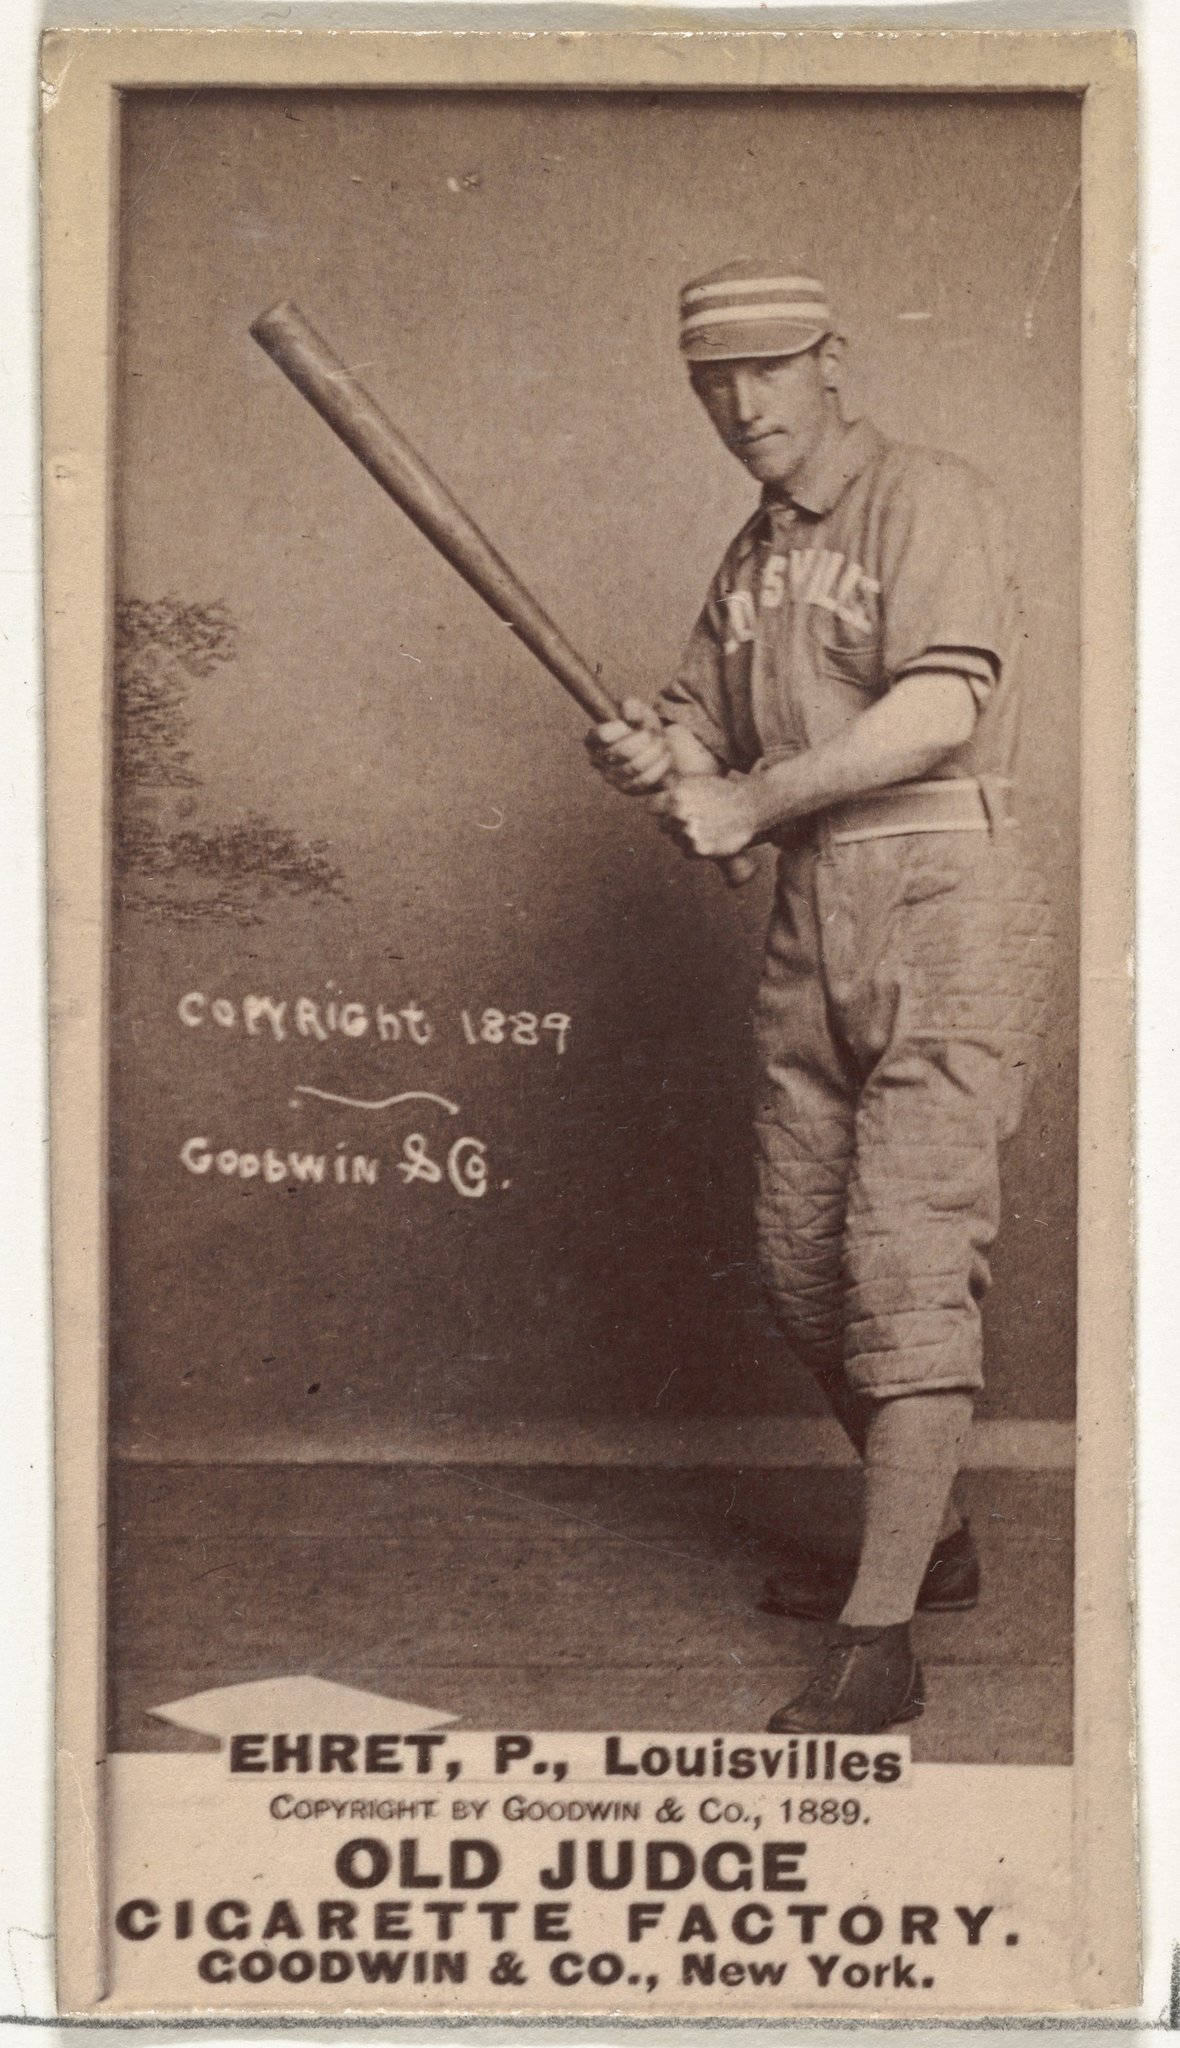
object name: baseball card, photograph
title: Philip Sydney "Red" Ehret, Pitcher, Louisville Colonels, from the Old Judge series (N172) for Old Judge Cigarettes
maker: goodwin & company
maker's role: publisher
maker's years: 1850-1950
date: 1889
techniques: albumen silver print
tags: men,portraits,baseball,athletes